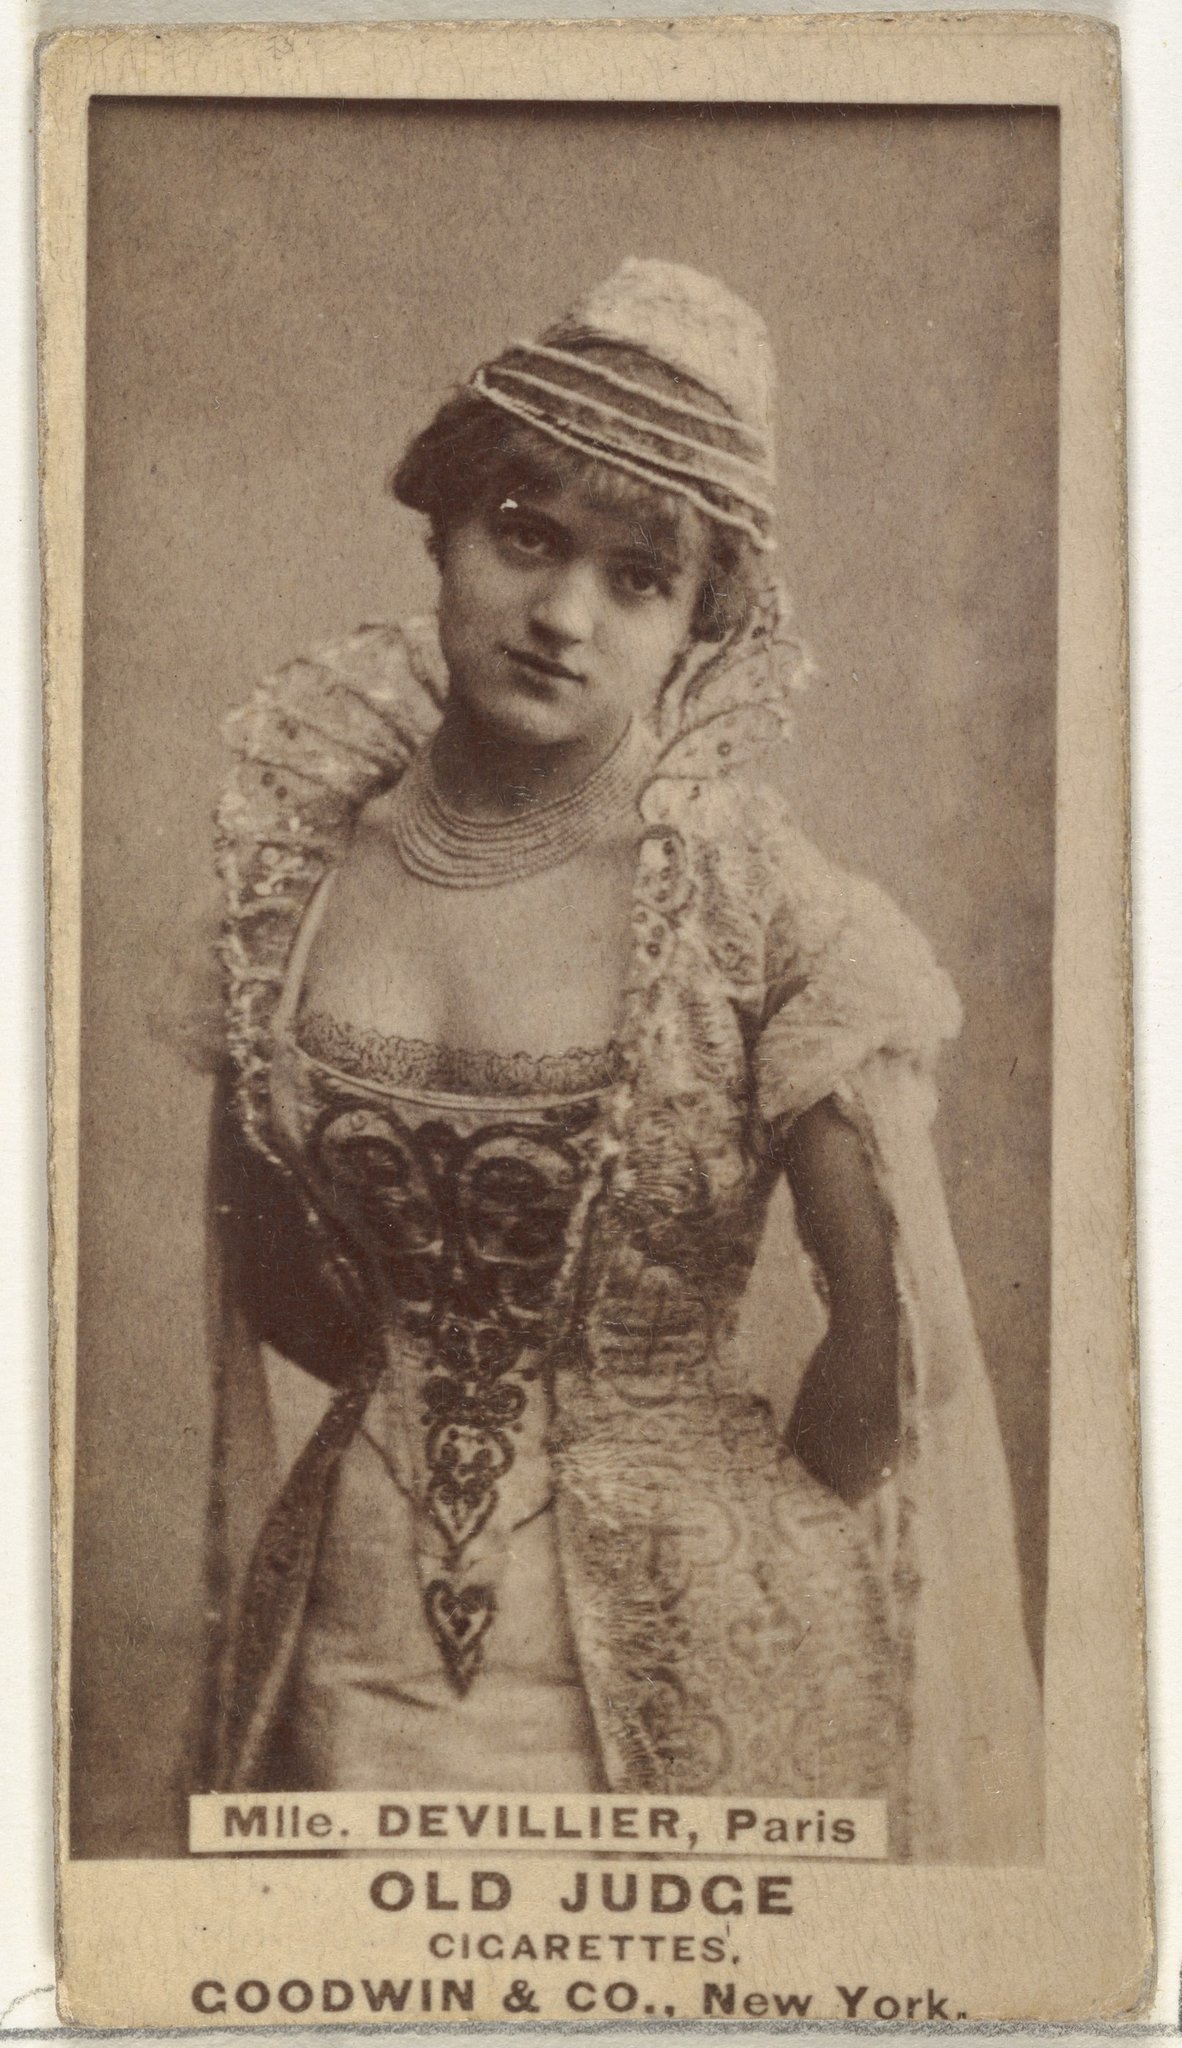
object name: photograph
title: Mlle. Devillier, Paris, from the Actors and Actresses series (N171) for Old Judge Cigarettes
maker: goodwin & company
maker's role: publisher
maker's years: 1850-1950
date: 1886-1890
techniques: albumen silver print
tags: portraits,women,actresses